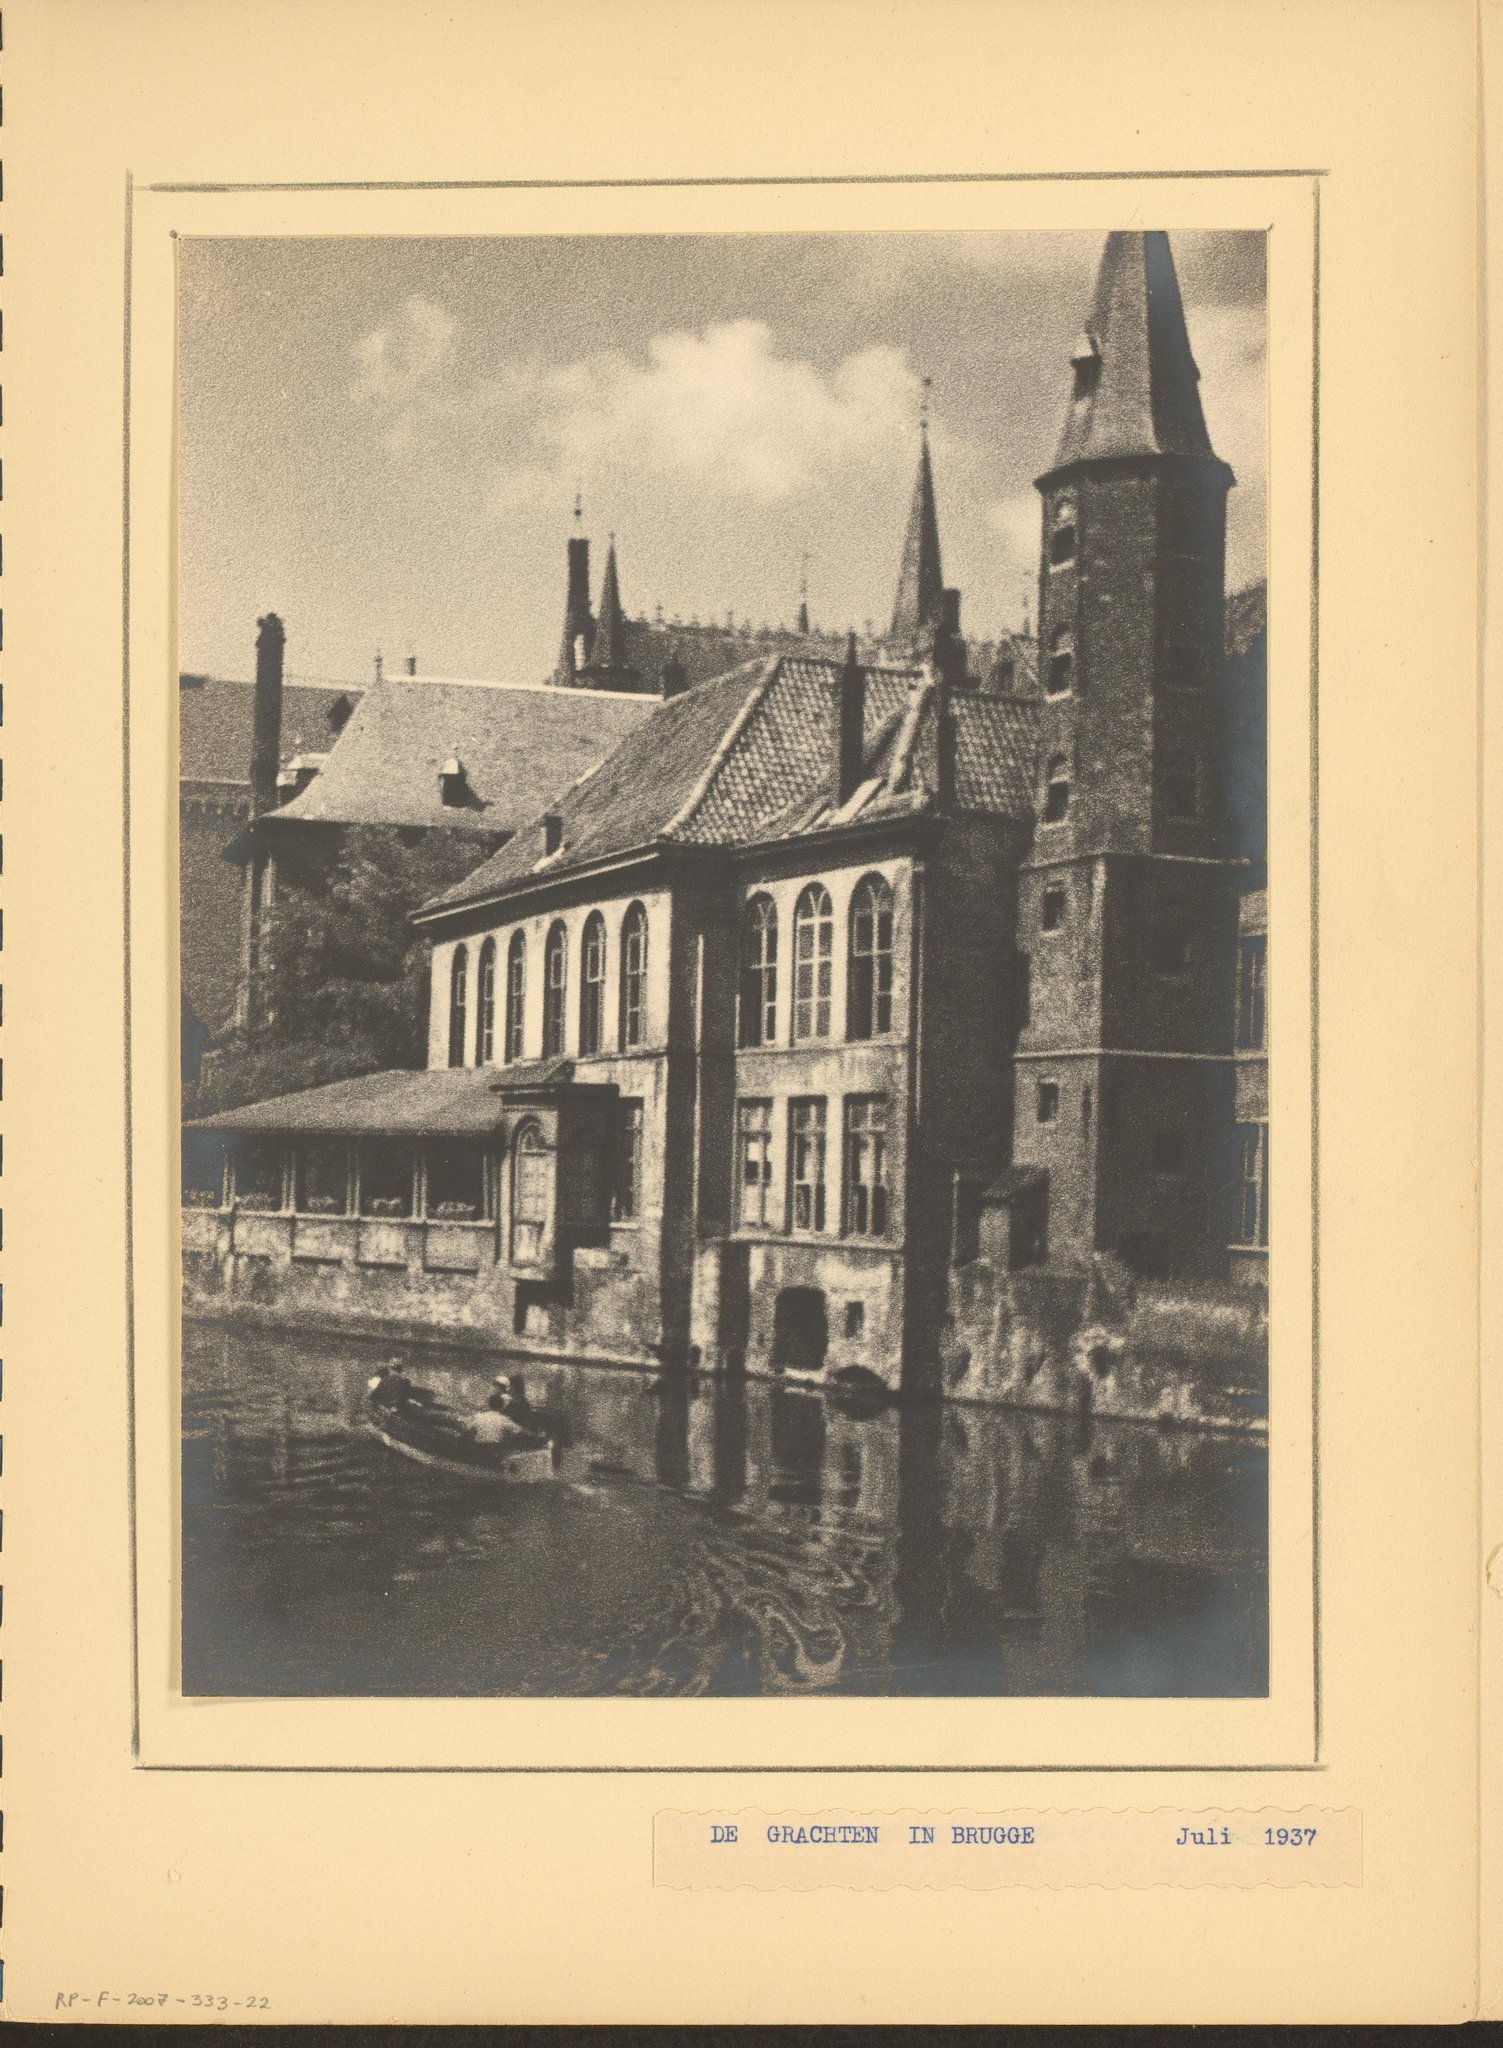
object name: photograph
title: De grachten in Brugge juli 1937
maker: gerrit elink schuurman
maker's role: fotograaf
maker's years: 1876-1953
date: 1907-1937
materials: paper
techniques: gelatin silver print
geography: bruges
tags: canals, waters (in city), bruges